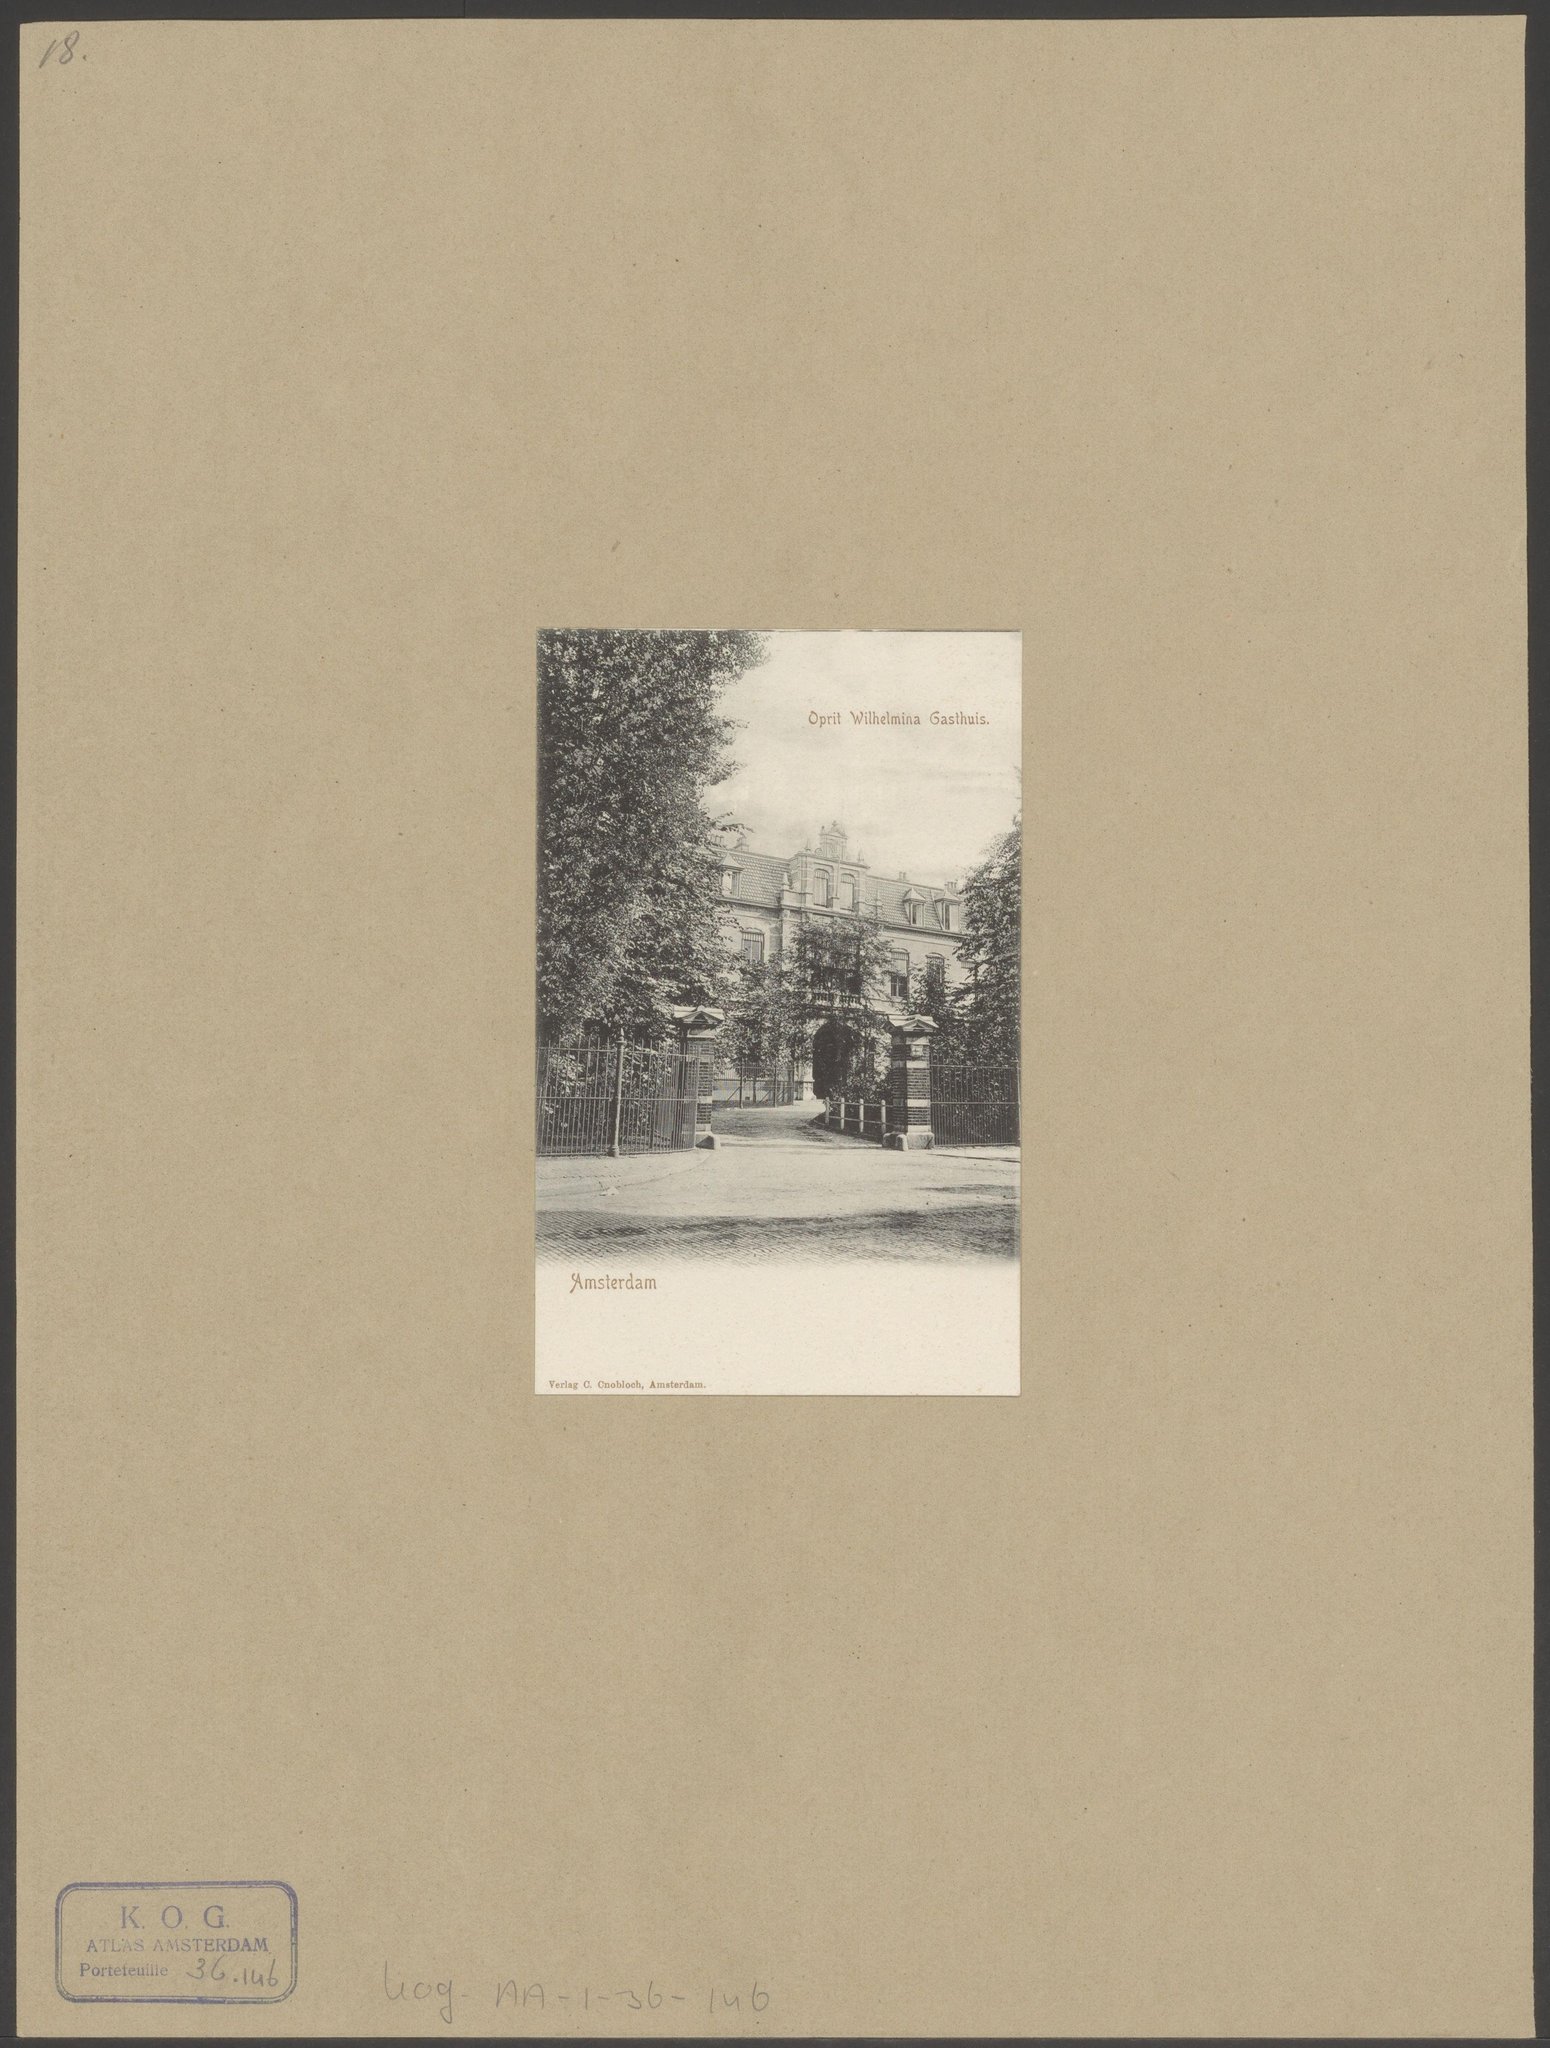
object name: photomechanical print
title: Oprit van het Wilhelmina Gasthuis te Amsterdam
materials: paper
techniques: photograph, letterpress printing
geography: amsterdam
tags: hospital, courtyard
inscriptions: collector's mark: Lugt 1641b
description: Oprit van het Wilhelmina Gasthuis te Amsterdam. Onderwerpsrubriek binnen de Atlas Amsterdam: Armwezen en liefdadige instellingen: I. Stadsinrichtingen: Wilhelminagasthuis.